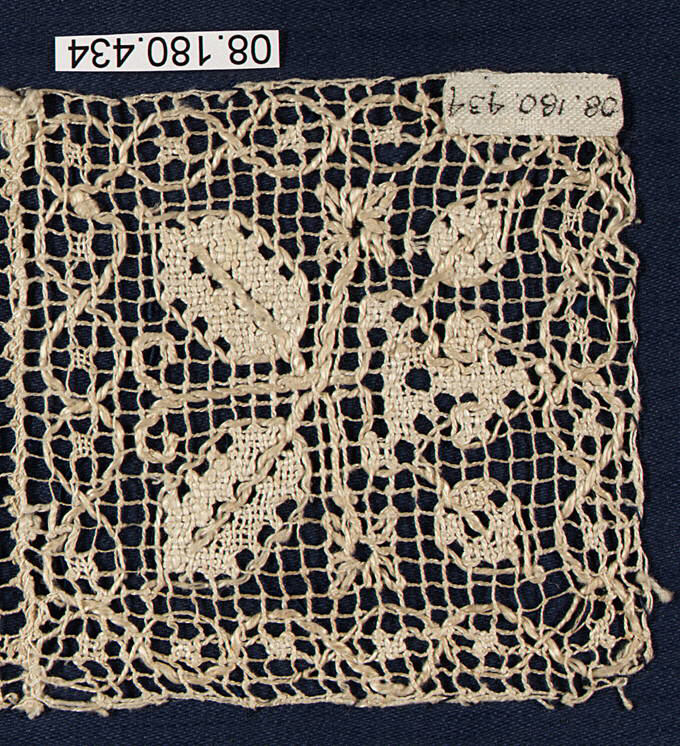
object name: square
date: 1601-1700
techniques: embroidery